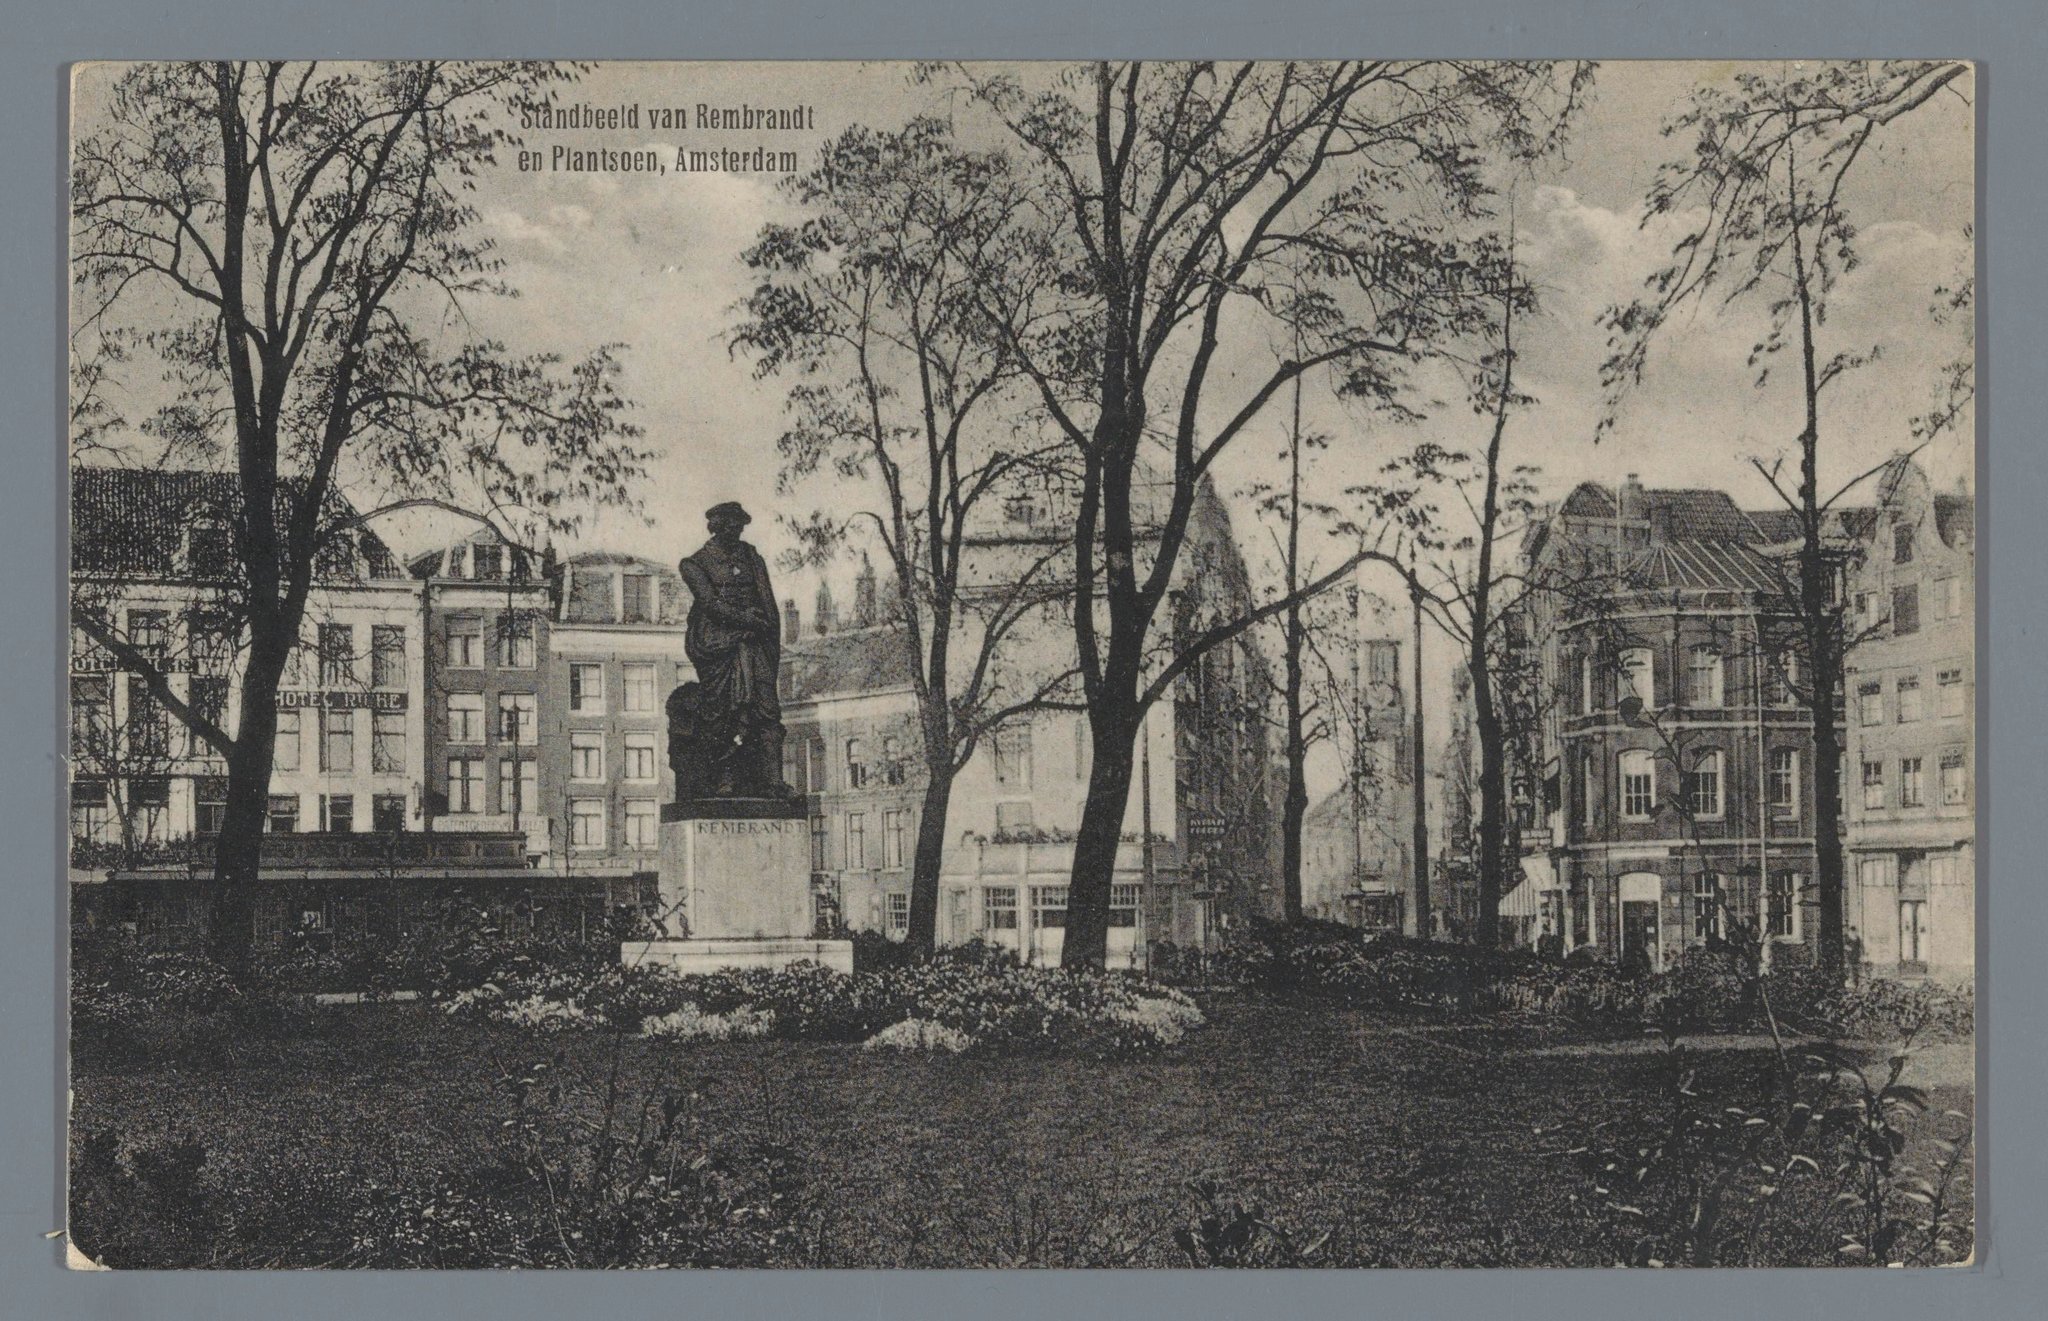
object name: photomechanical print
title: Standbeeld van Rembrandt/ en Plantsoen, Amsterdam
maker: Anonymous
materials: cardboard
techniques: photograph, writing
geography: amsterdam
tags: leiden, amsterdam, painter, print maker, draughtsman, rembrandt van rijn, park, monument, statue